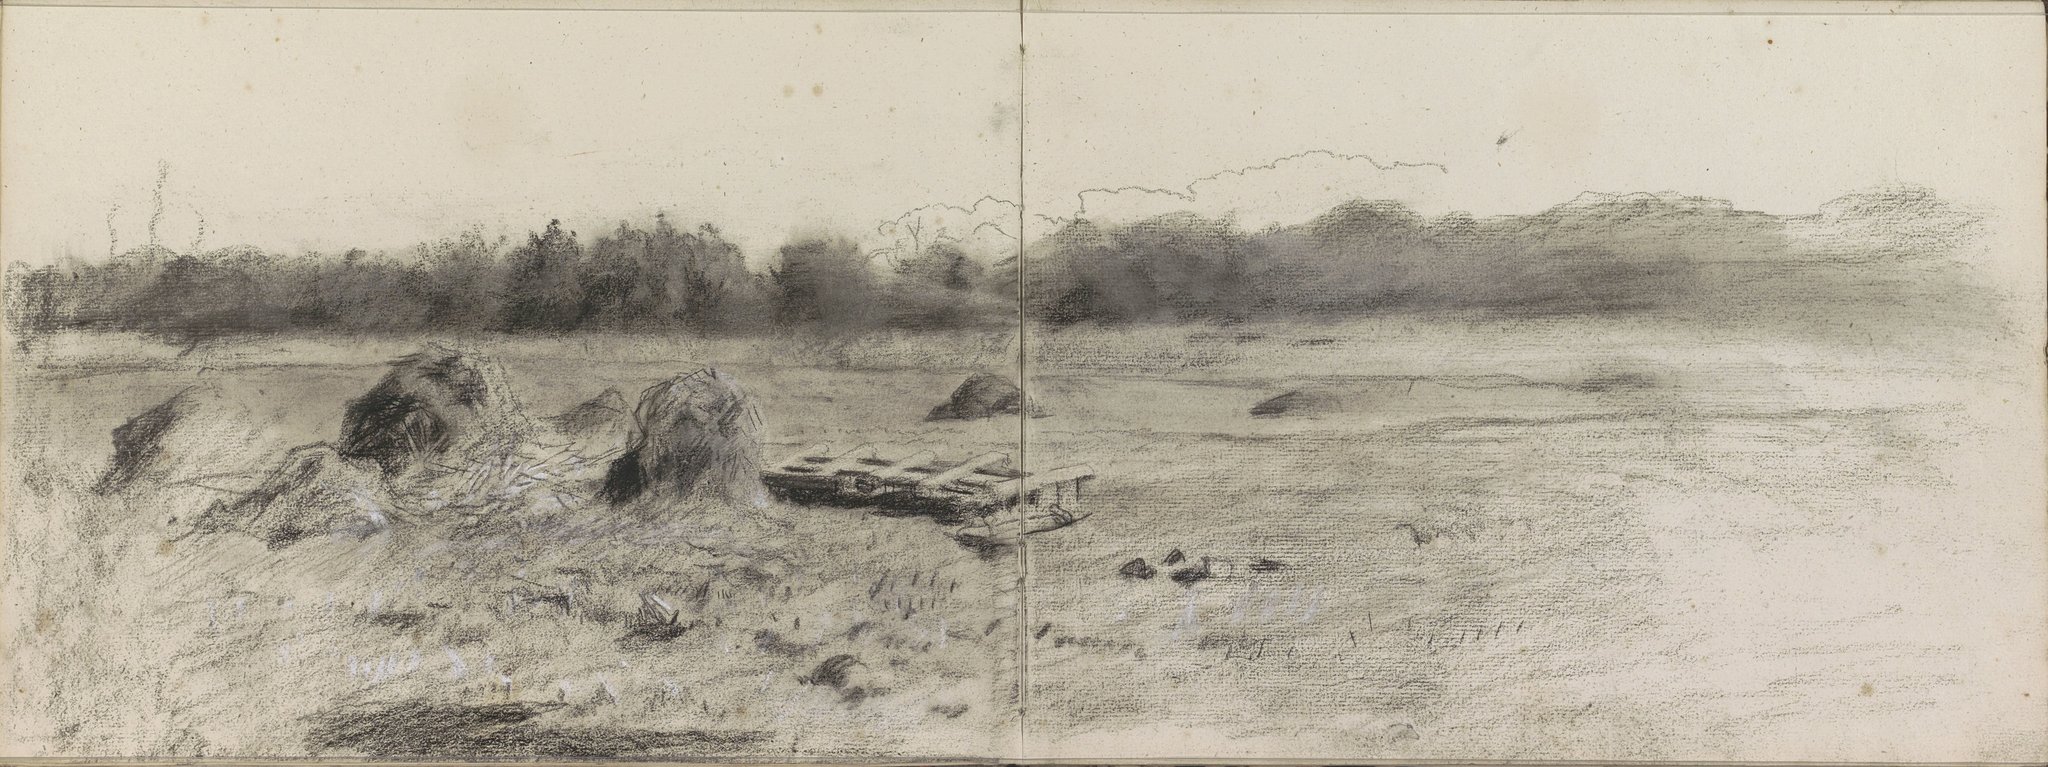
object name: sketchbook leaf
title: Hooibalen in een landschap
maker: anton mauve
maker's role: draughtsman, painter, print maker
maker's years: 1838-1888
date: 1848-1888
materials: chalk, paint, paper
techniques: brush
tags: landscapes, hay-stack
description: Blad 2 verso en 3 recto uit een schetsboek met 34 bladen.